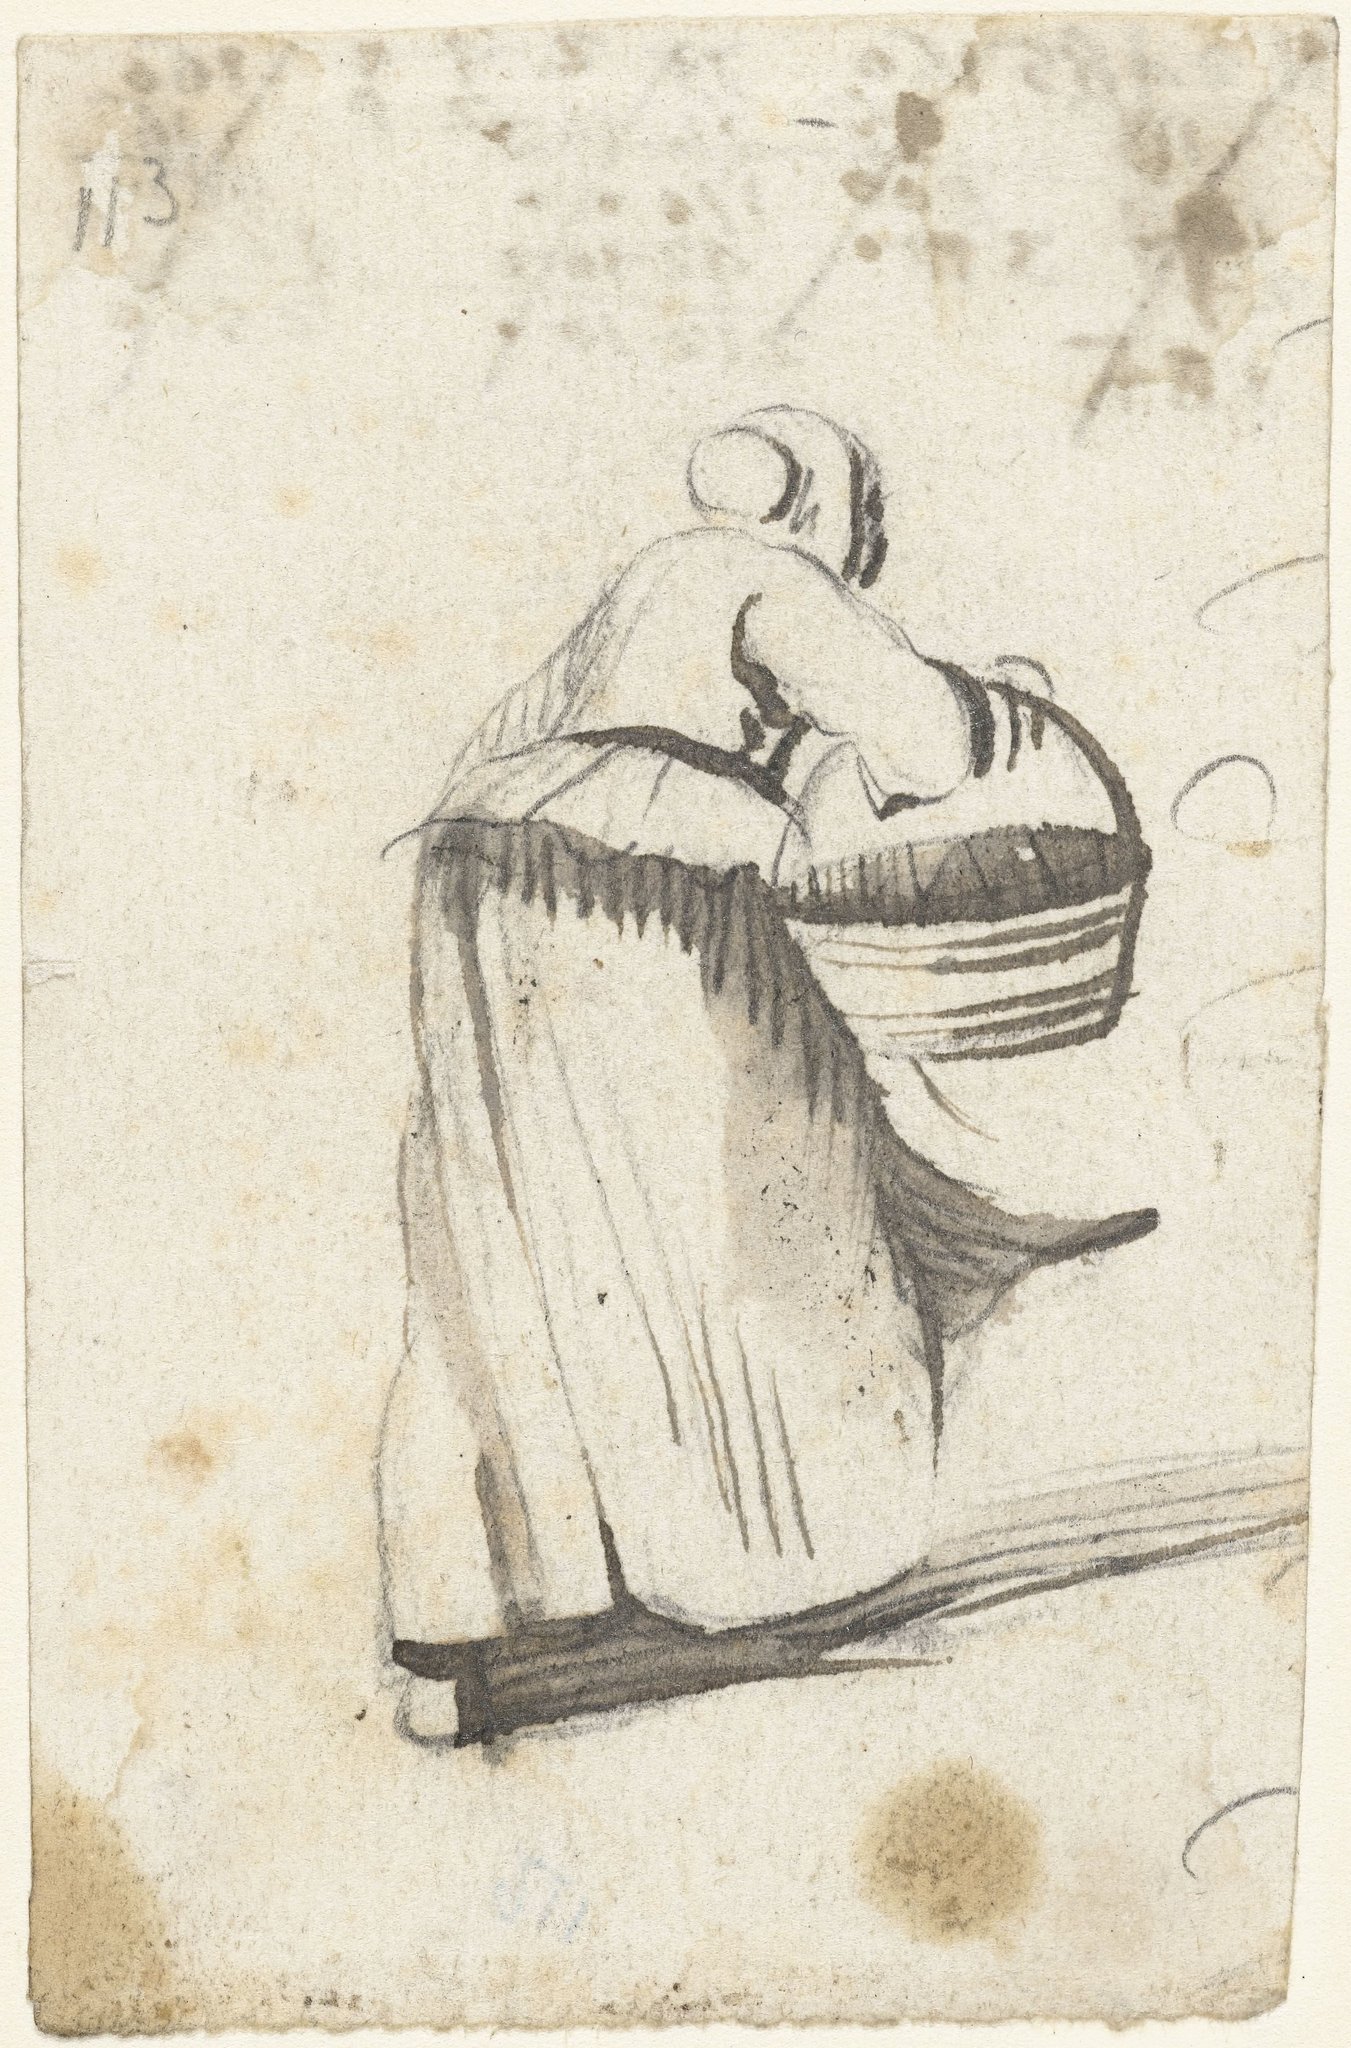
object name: drawing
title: Lopende vrouw met mand, naar rechts, van achteren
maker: harmen ter borch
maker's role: draughtsman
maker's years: 1638-1677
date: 1610-1651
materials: chalk, ink, paper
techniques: brush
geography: zwolle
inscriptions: annotation